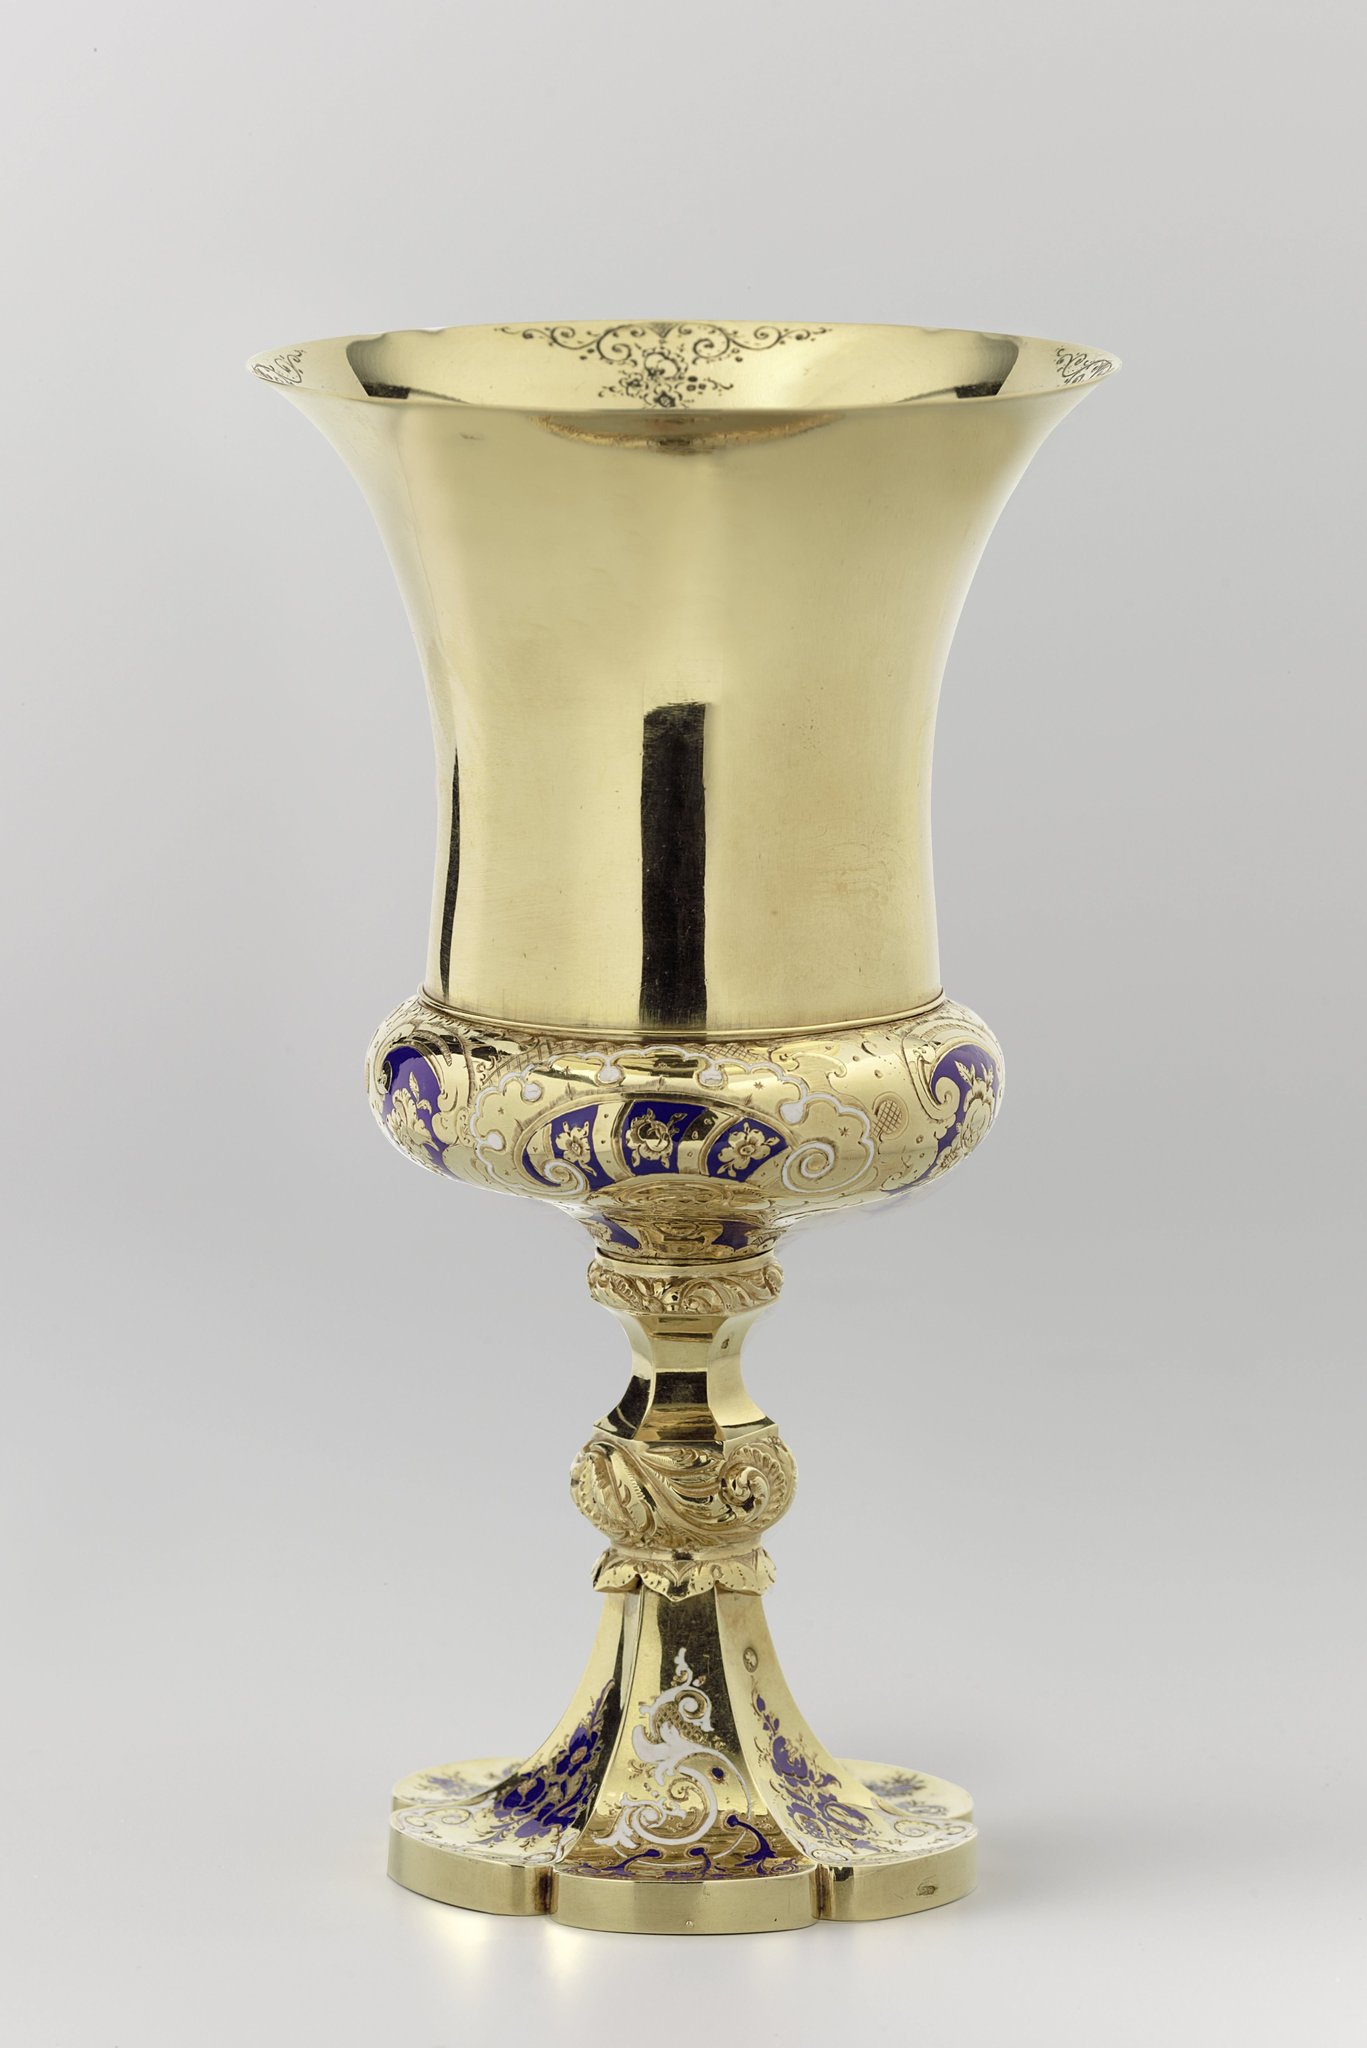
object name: drinking vessel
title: Chalice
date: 1849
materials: gold, wood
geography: amsterdam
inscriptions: maker's mark, alloy mark, assay office mark, date letter: ‘P’, hallmark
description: De zeslobbige, gewelfde, zich sterk verjongende, hoge voet rust op een rechtwandige bais. Hij wordt aan de bovenzijde afgesloten door een overkragende, geschulpte rand. Hierboven rijst de stam op, die is opgebouwd uit een gedrukte nodus, in reliëf versierd met voluten. De klokvormige cuppa heeft een bolvormig ondergedeelte. De lobben van de voet zijn versierd met afwisselend een patroon van symmetrisch geplaatste C-voluten van wit email en een bloemtak van blauwe email, ter weerszijden van een asymmetrsiche S-voluut van wit email waaraan een bloem en twee voluten van blauw email ontspruiten. Het bolvormig gedeelte van de cuppa is versierd met deels gegraveerde, deels in blauw en wit email uitgevoerde voluten en rocailles, waarin bloemen en ruitpatronen zijn verwerkt. Aan de binnenzijde van de cuppa is vier maal eenzelfde versiering gegraveerd van een syymetrisch geplaatste C-voluten hangende bloemen.